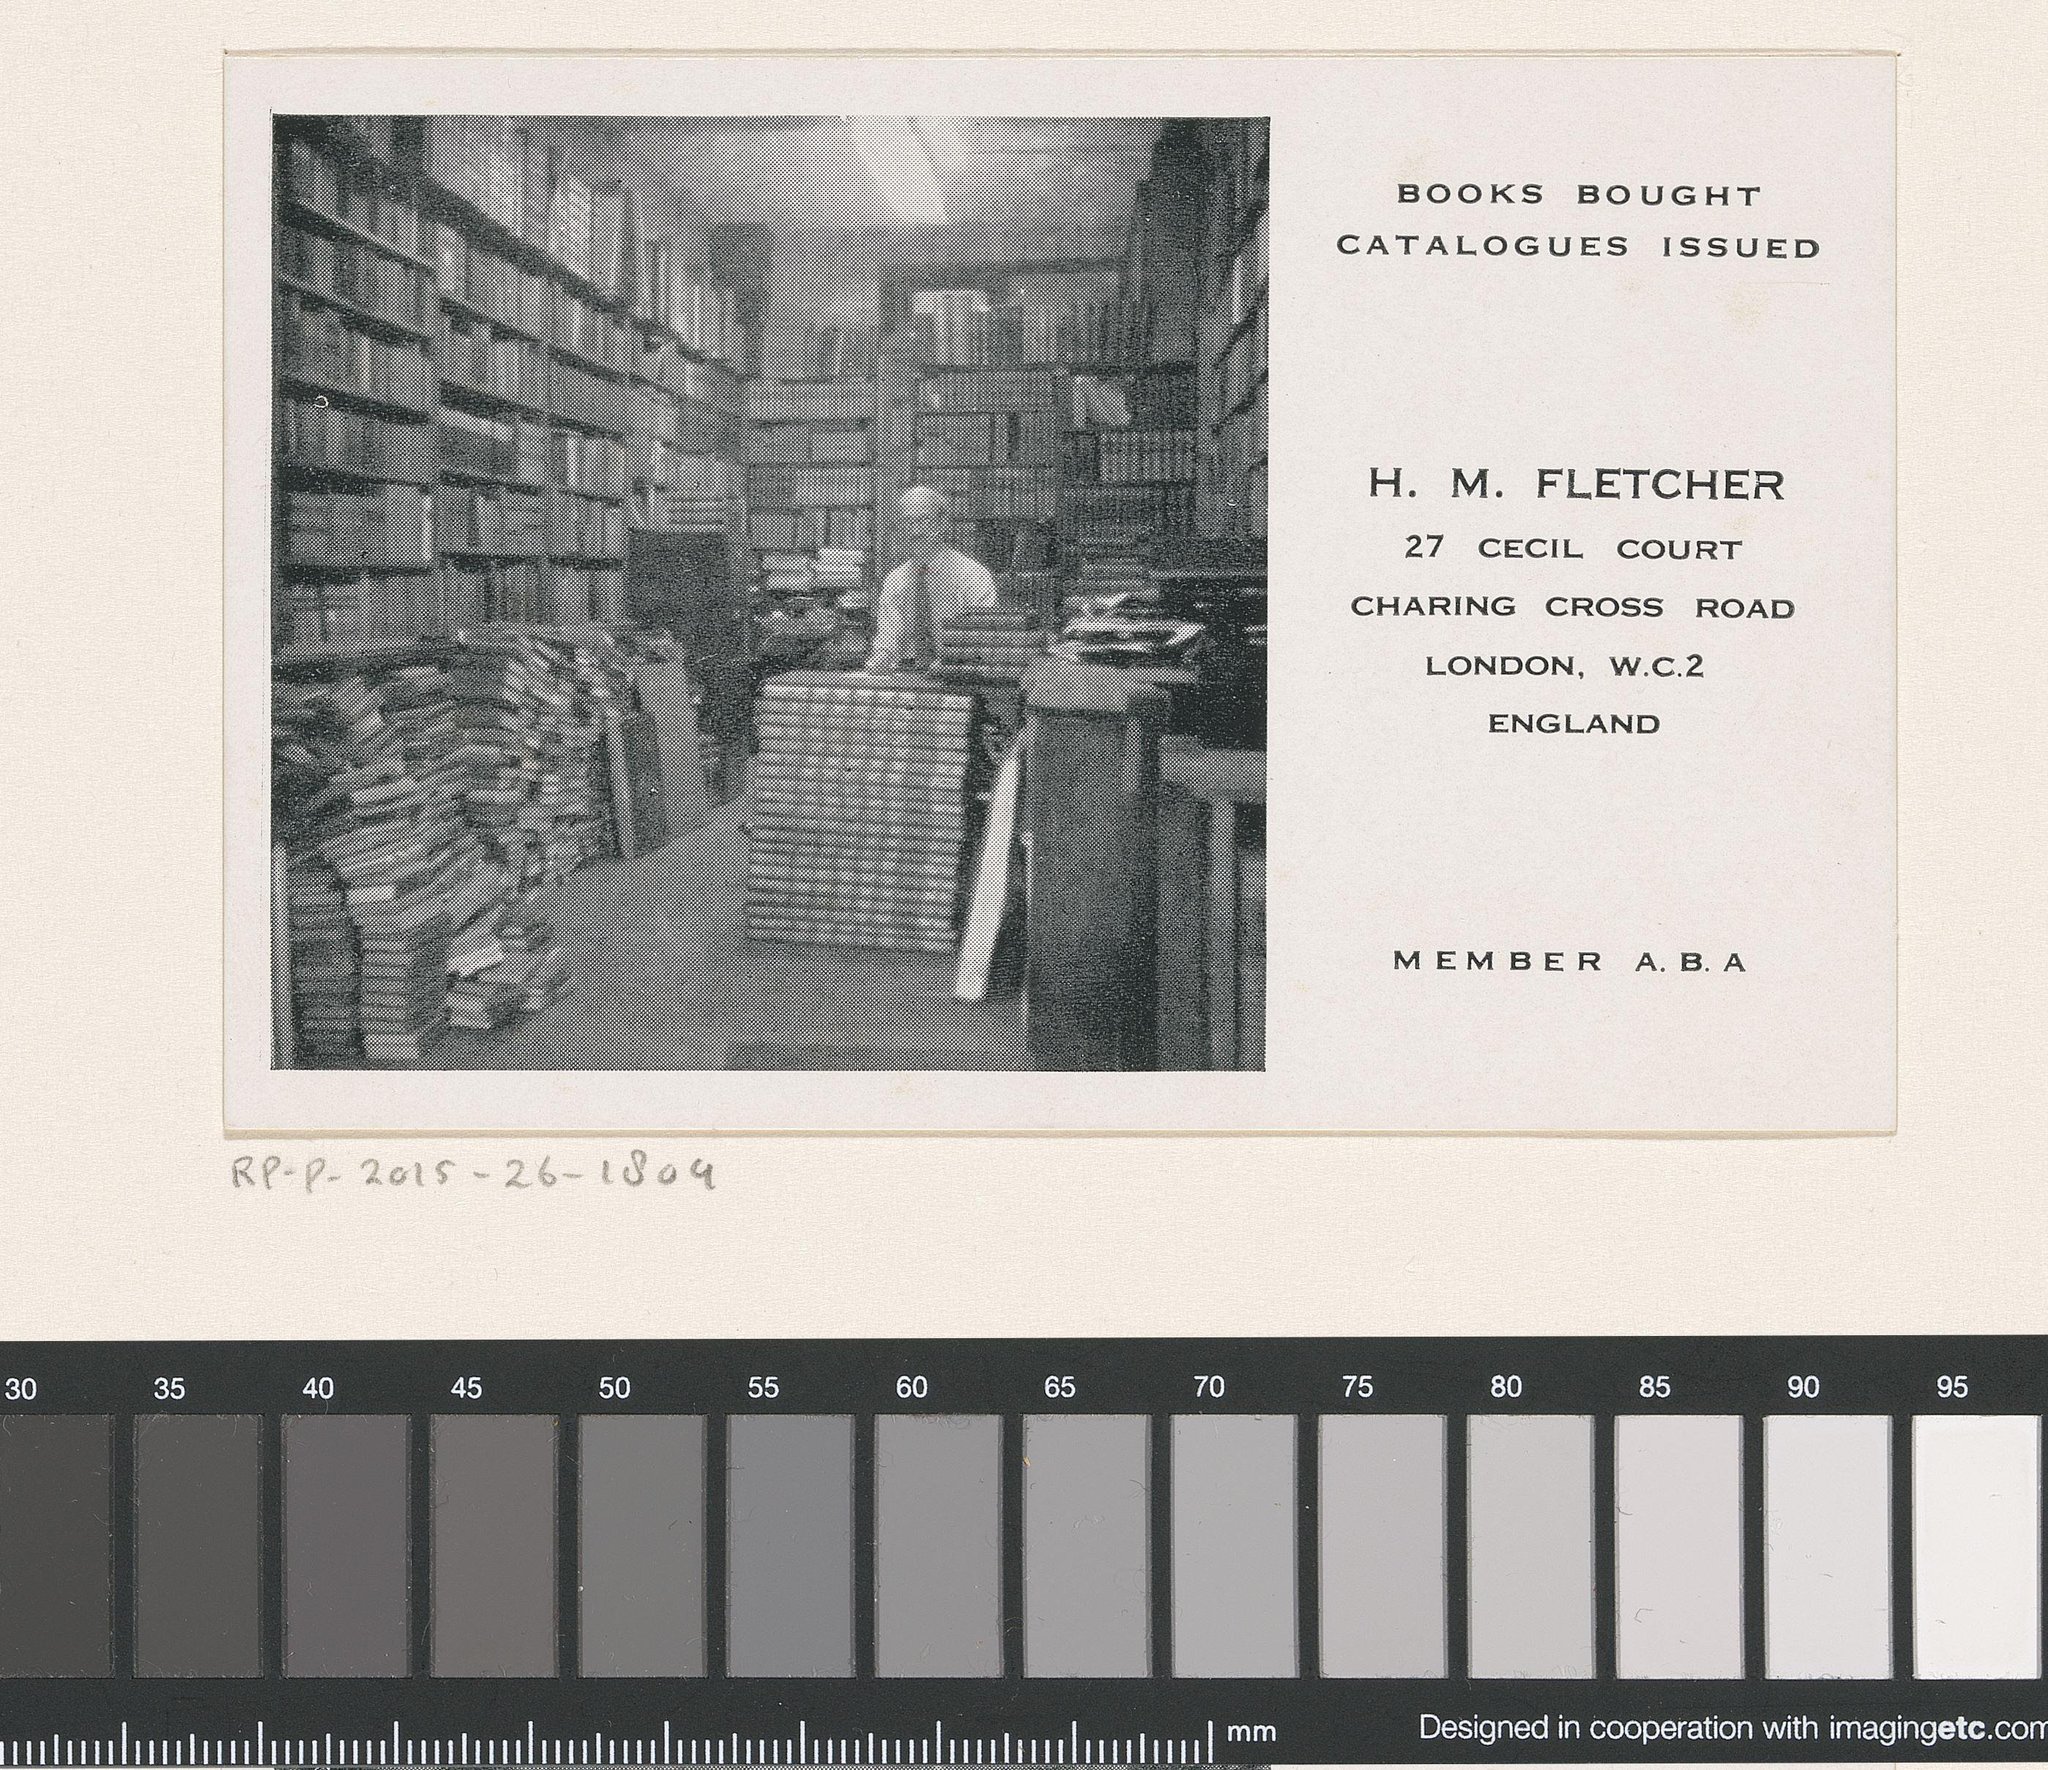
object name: print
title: Visitekaartje van H.M. Fletcher, boekhandelaar te Londen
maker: Anonymous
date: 1950-1996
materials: paper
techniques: autotype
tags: book-shop, bookseller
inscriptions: collector's mark: Lugt 2228, annotation: ‘Will send you a third / card when I get a / book to quote you / yours BF’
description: Interieur van de boekhandel met op de grond stapels boeken. Achter een van de stapels staat een man, waarschijnlijk de eigenaar, Bill Fletcher.